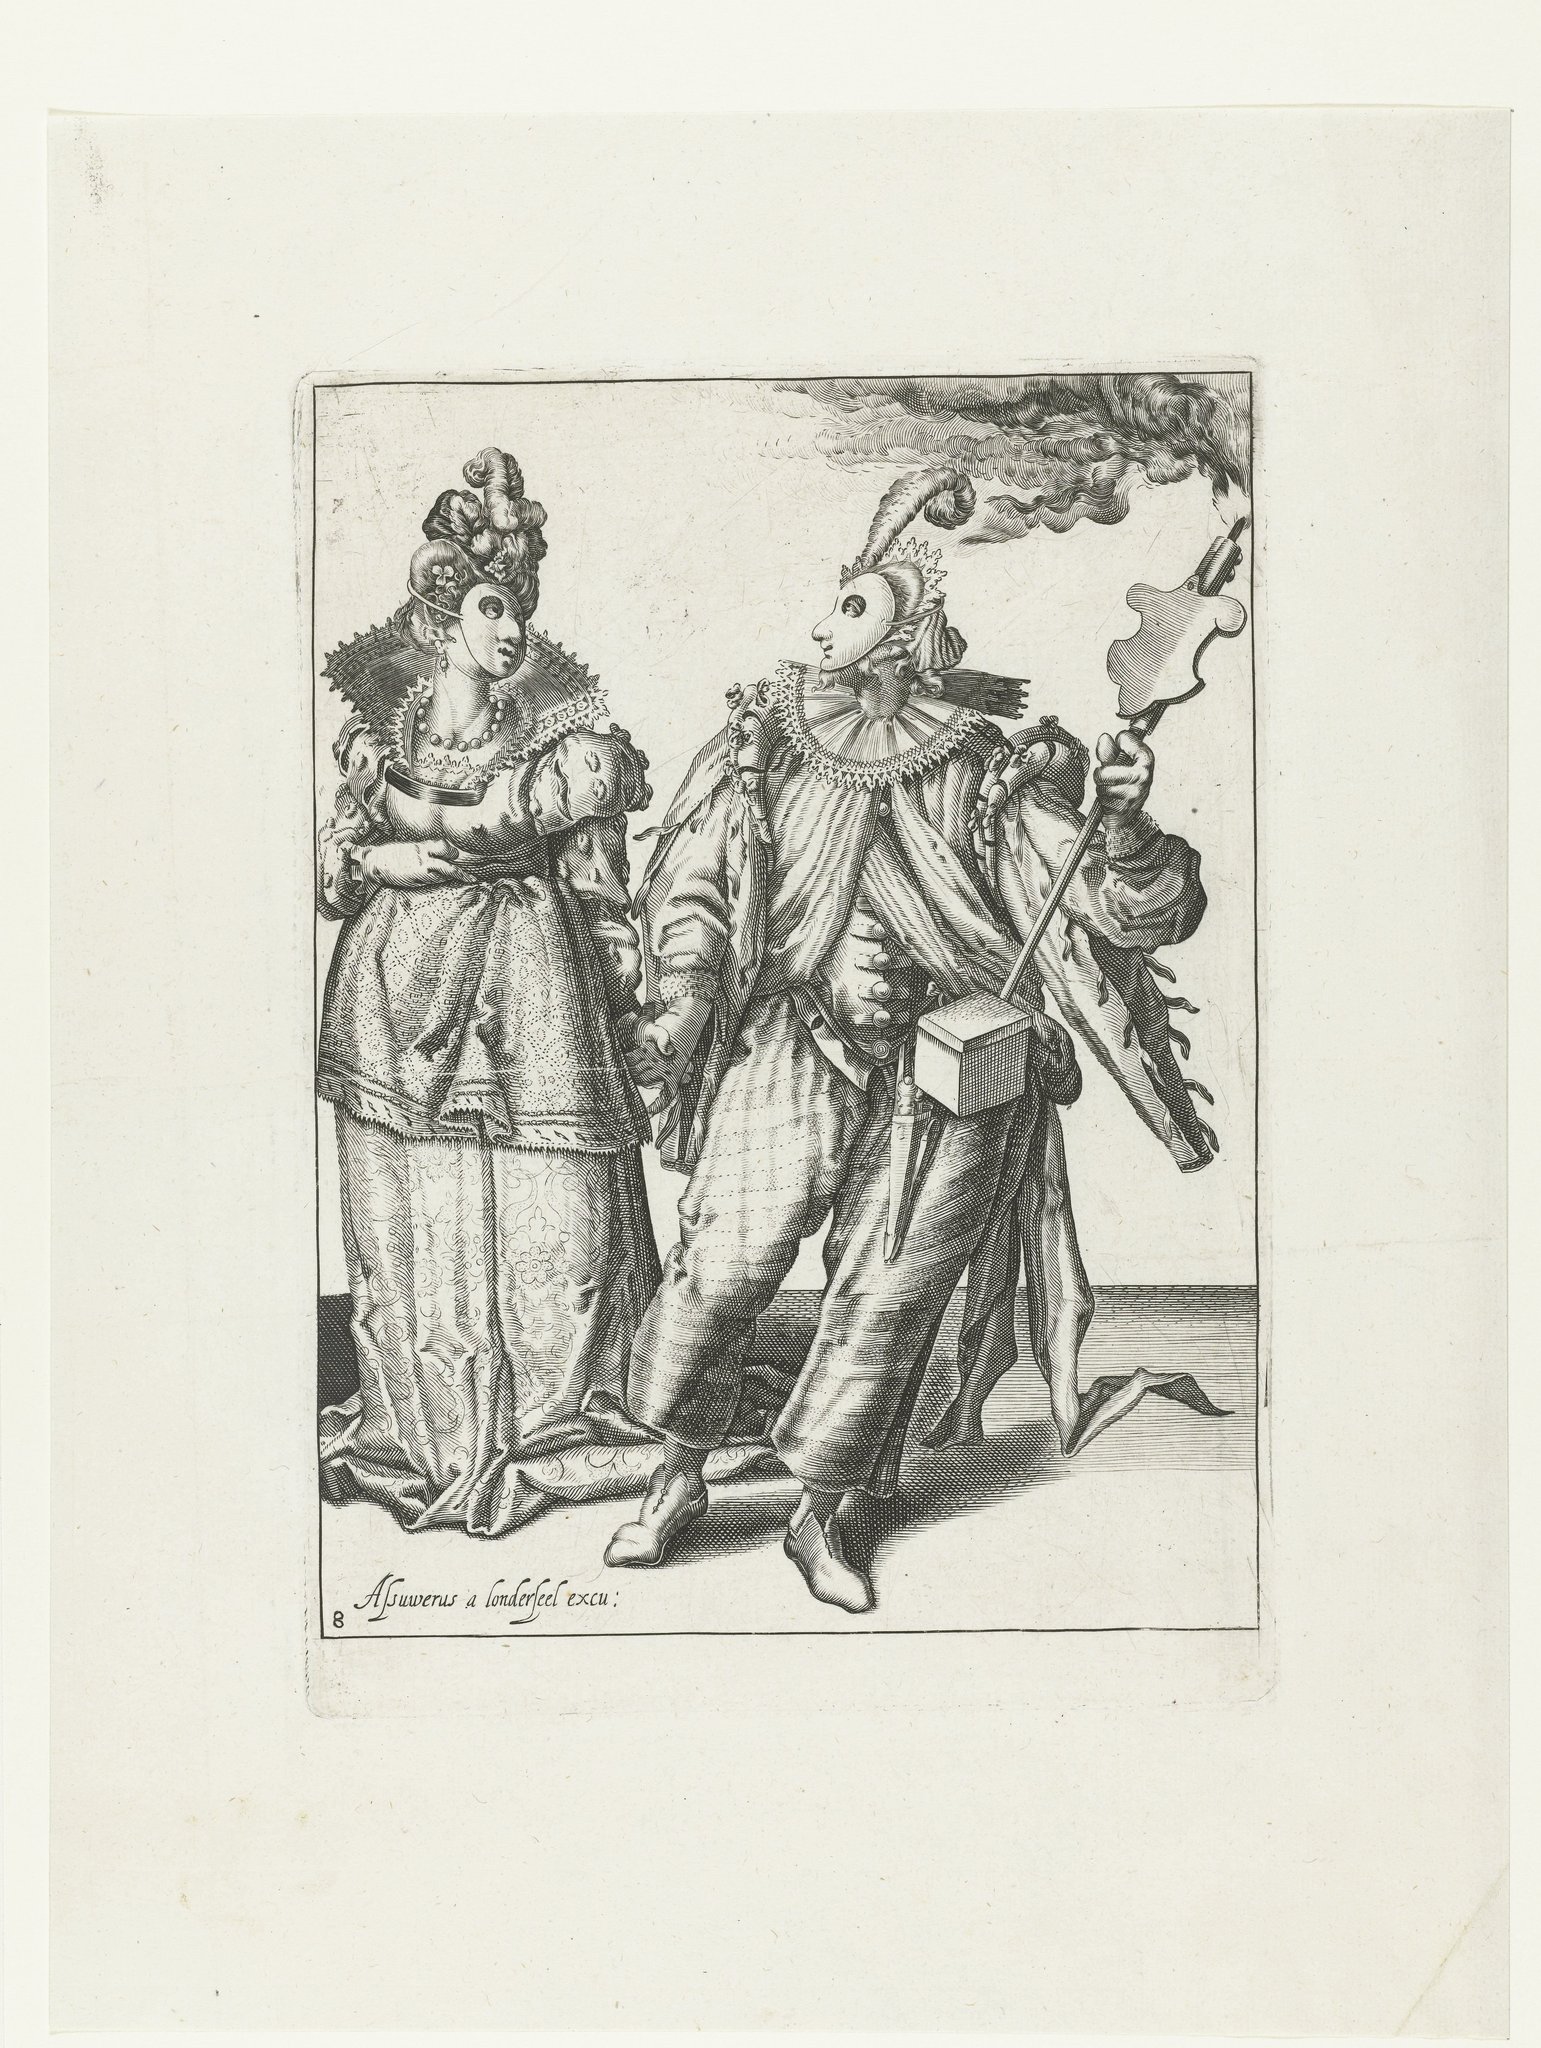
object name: print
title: De maskerades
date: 1596-1635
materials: paper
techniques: engraving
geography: netherlands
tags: mask, torch, masquerade, masked ball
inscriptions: collector's mark: Lugt 2228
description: Een gemaskerde vrouw in feestelijke kledij wordt aan de hand meegevoerd door een gemaskerde man in feestelijke kledij met een fakkel. Deze prent is onderdeel van een serie van negen genummerde prenten, waarop twee of drie gemaskerde en/of verklede figuren ten voeten uit zijn weergegeven.